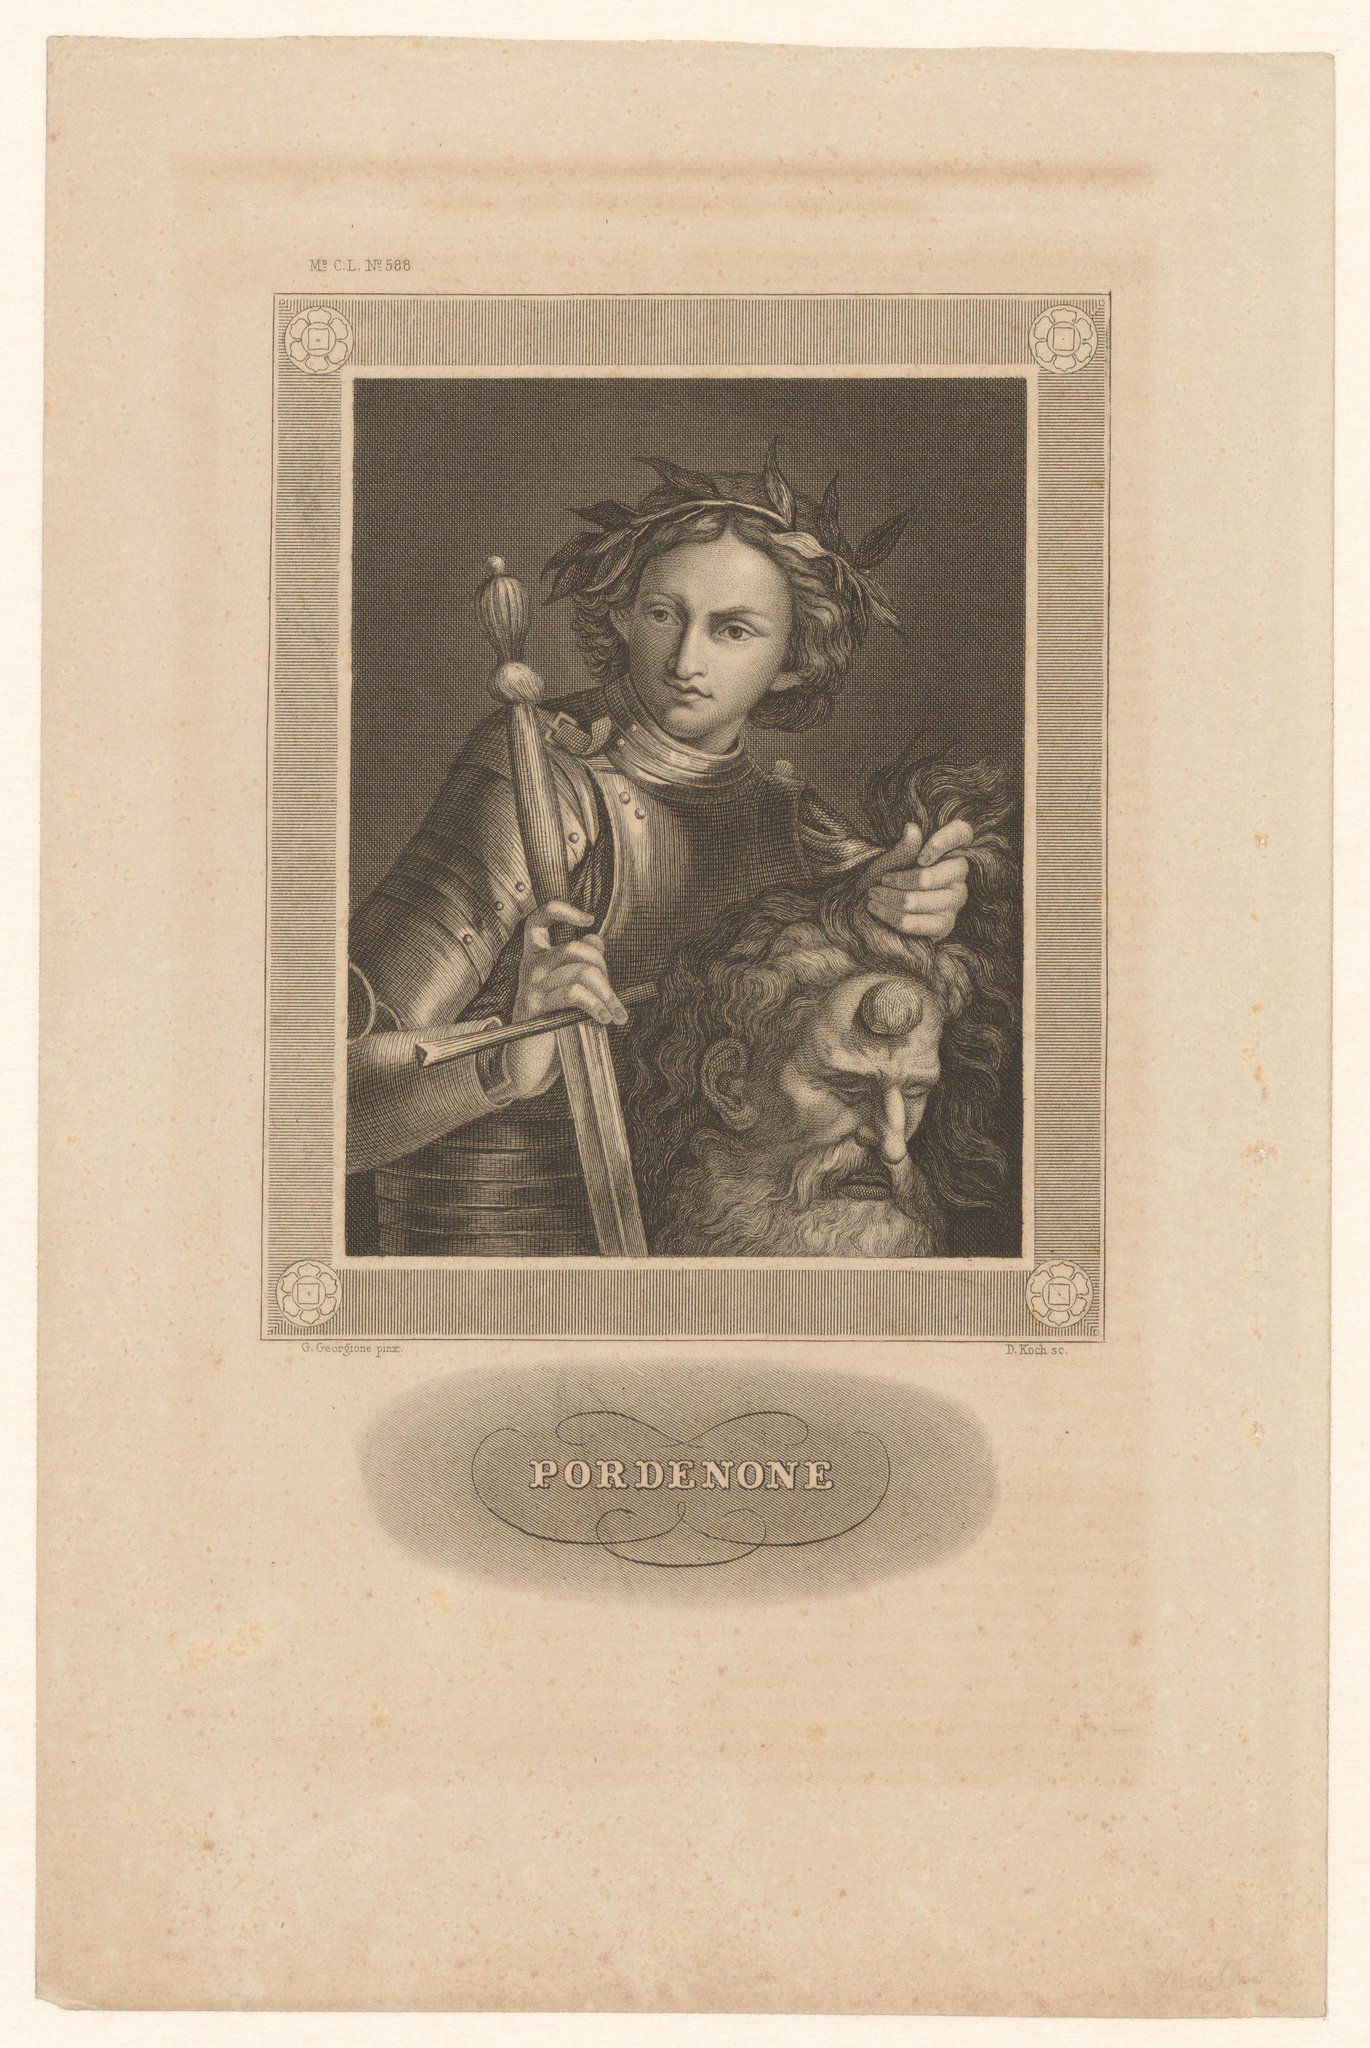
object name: book illustration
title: Portret van Pordenone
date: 1840-1855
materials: paper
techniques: engraving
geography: hildburghausen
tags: painter, print maker, draughtsman, pordenone, david with goliath's head, historical persons, portrait, self-portrait of painter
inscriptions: collector's mark: Lugt 2228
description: Prent uit: Meyer, Joseph. Das Grosse Conversations-Lexikon für die gebildeten Stände. Hildburghausen: Bibliographisches Institut, [1840-1855].